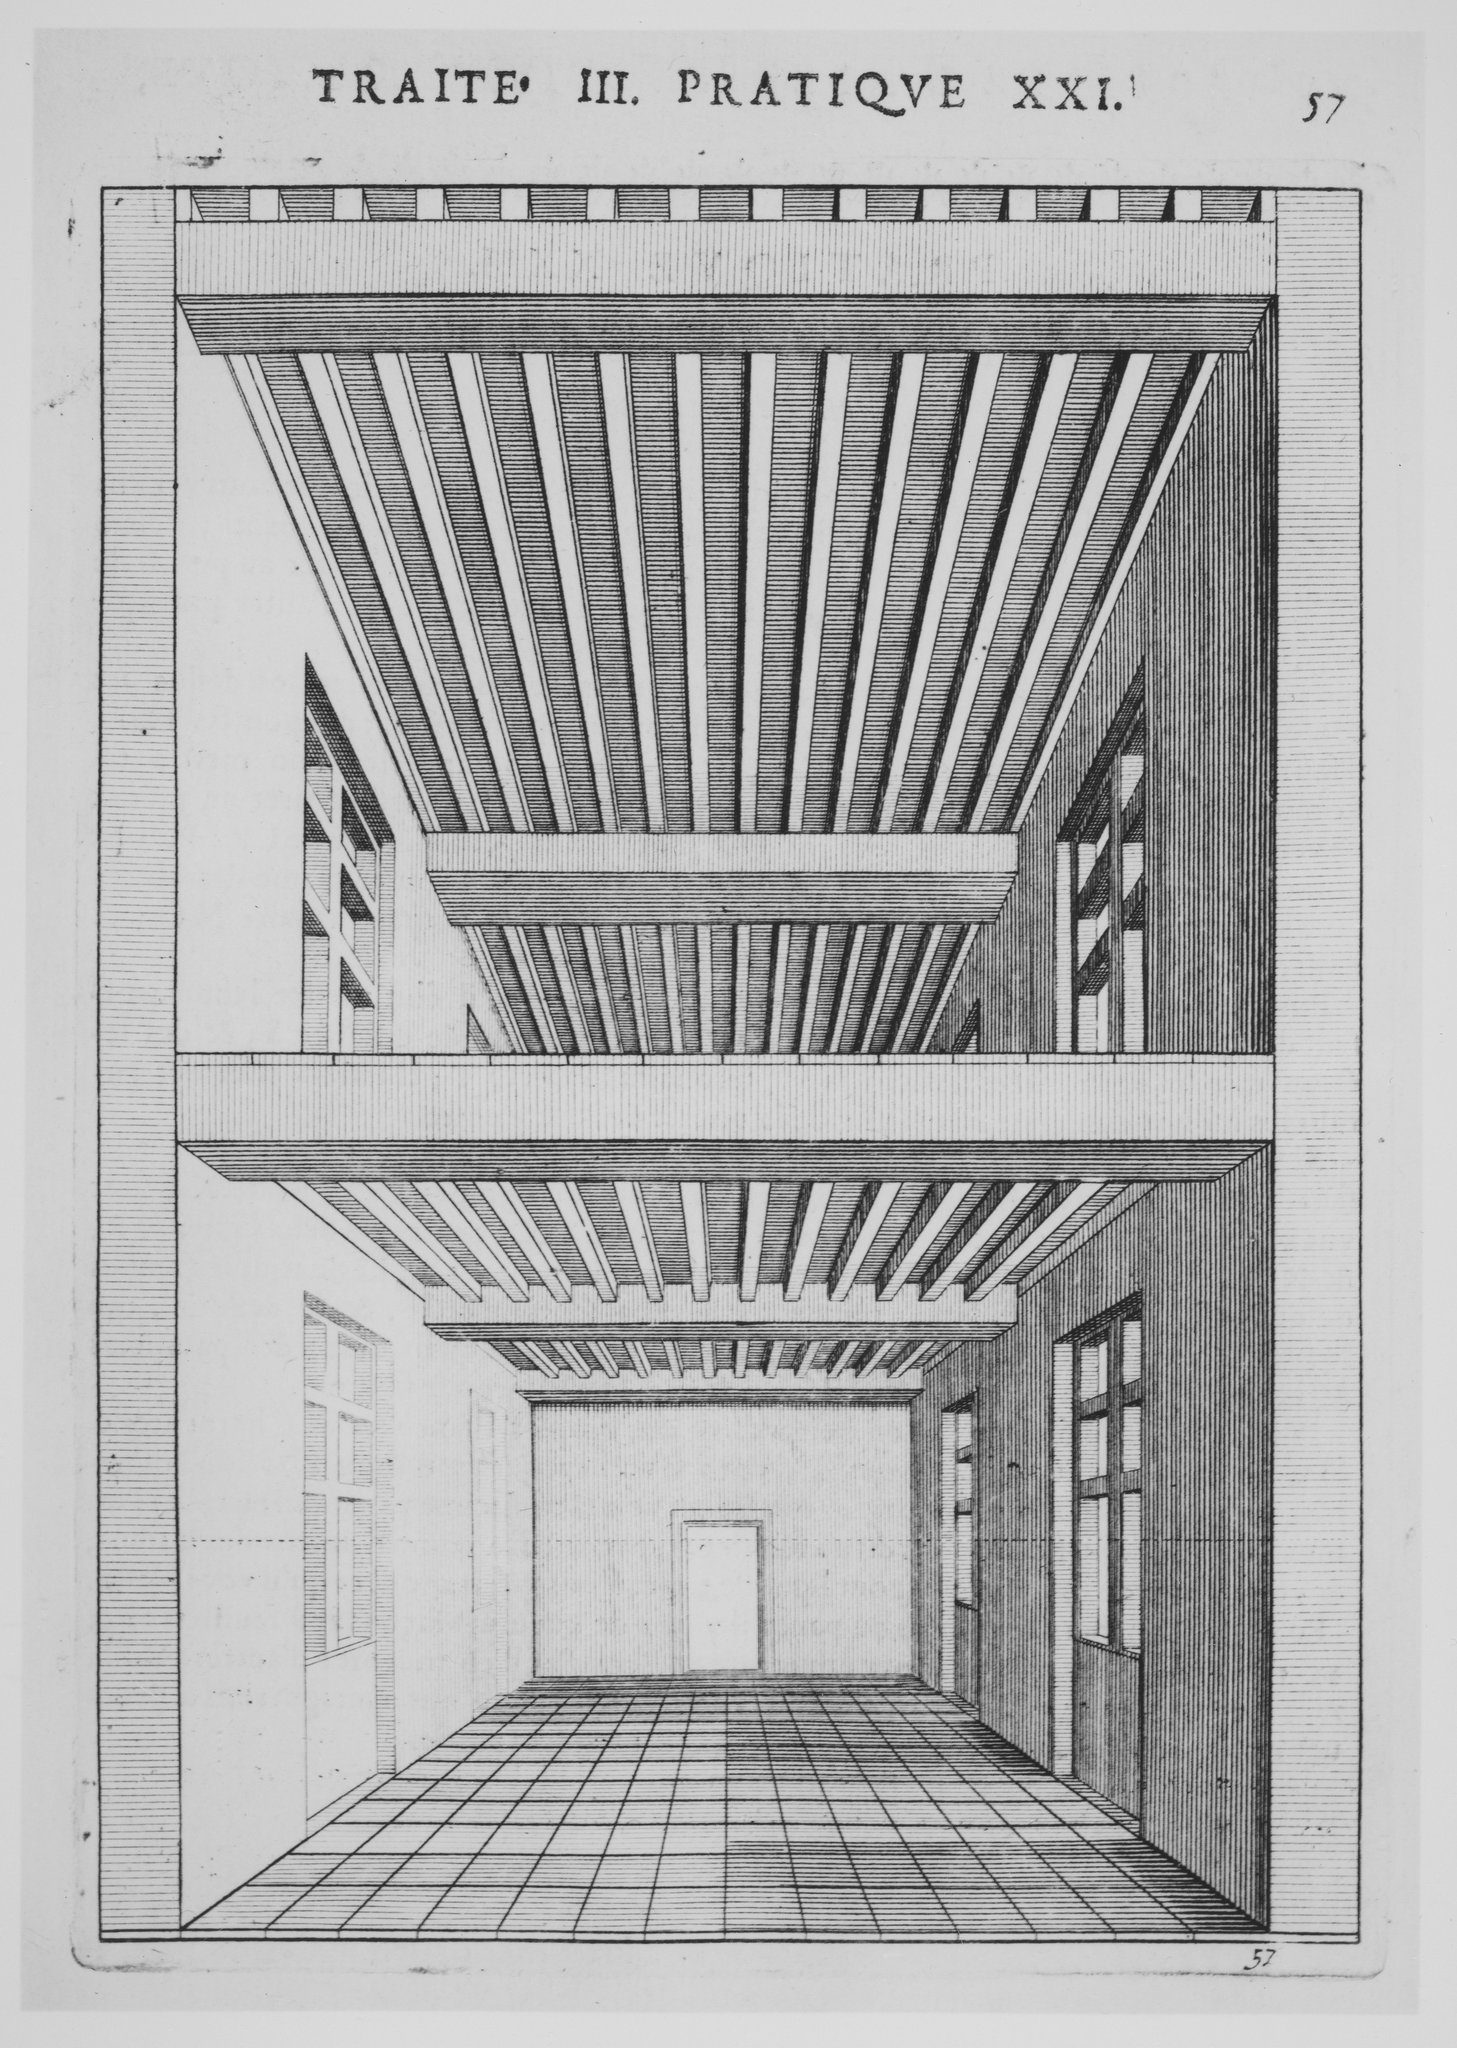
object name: book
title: La Perspective Pratique. Seconde Edition. Part I, II, and III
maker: jean dubreuil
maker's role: author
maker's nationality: french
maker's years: 1602-1670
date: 1679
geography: france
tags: doors,interiors